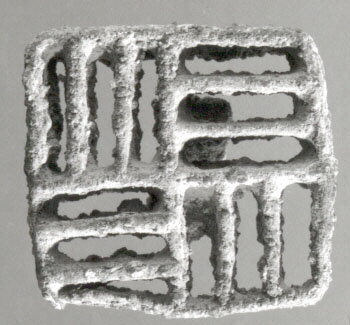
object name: stamp seal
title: Compartmented stamp seal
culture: bactria-margiana archaeological complex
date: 2333-1668 BCE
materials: copper alloy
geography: bactria-margiana